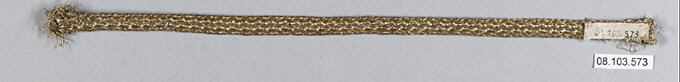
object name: galloon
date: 1701-1800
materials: metal thread